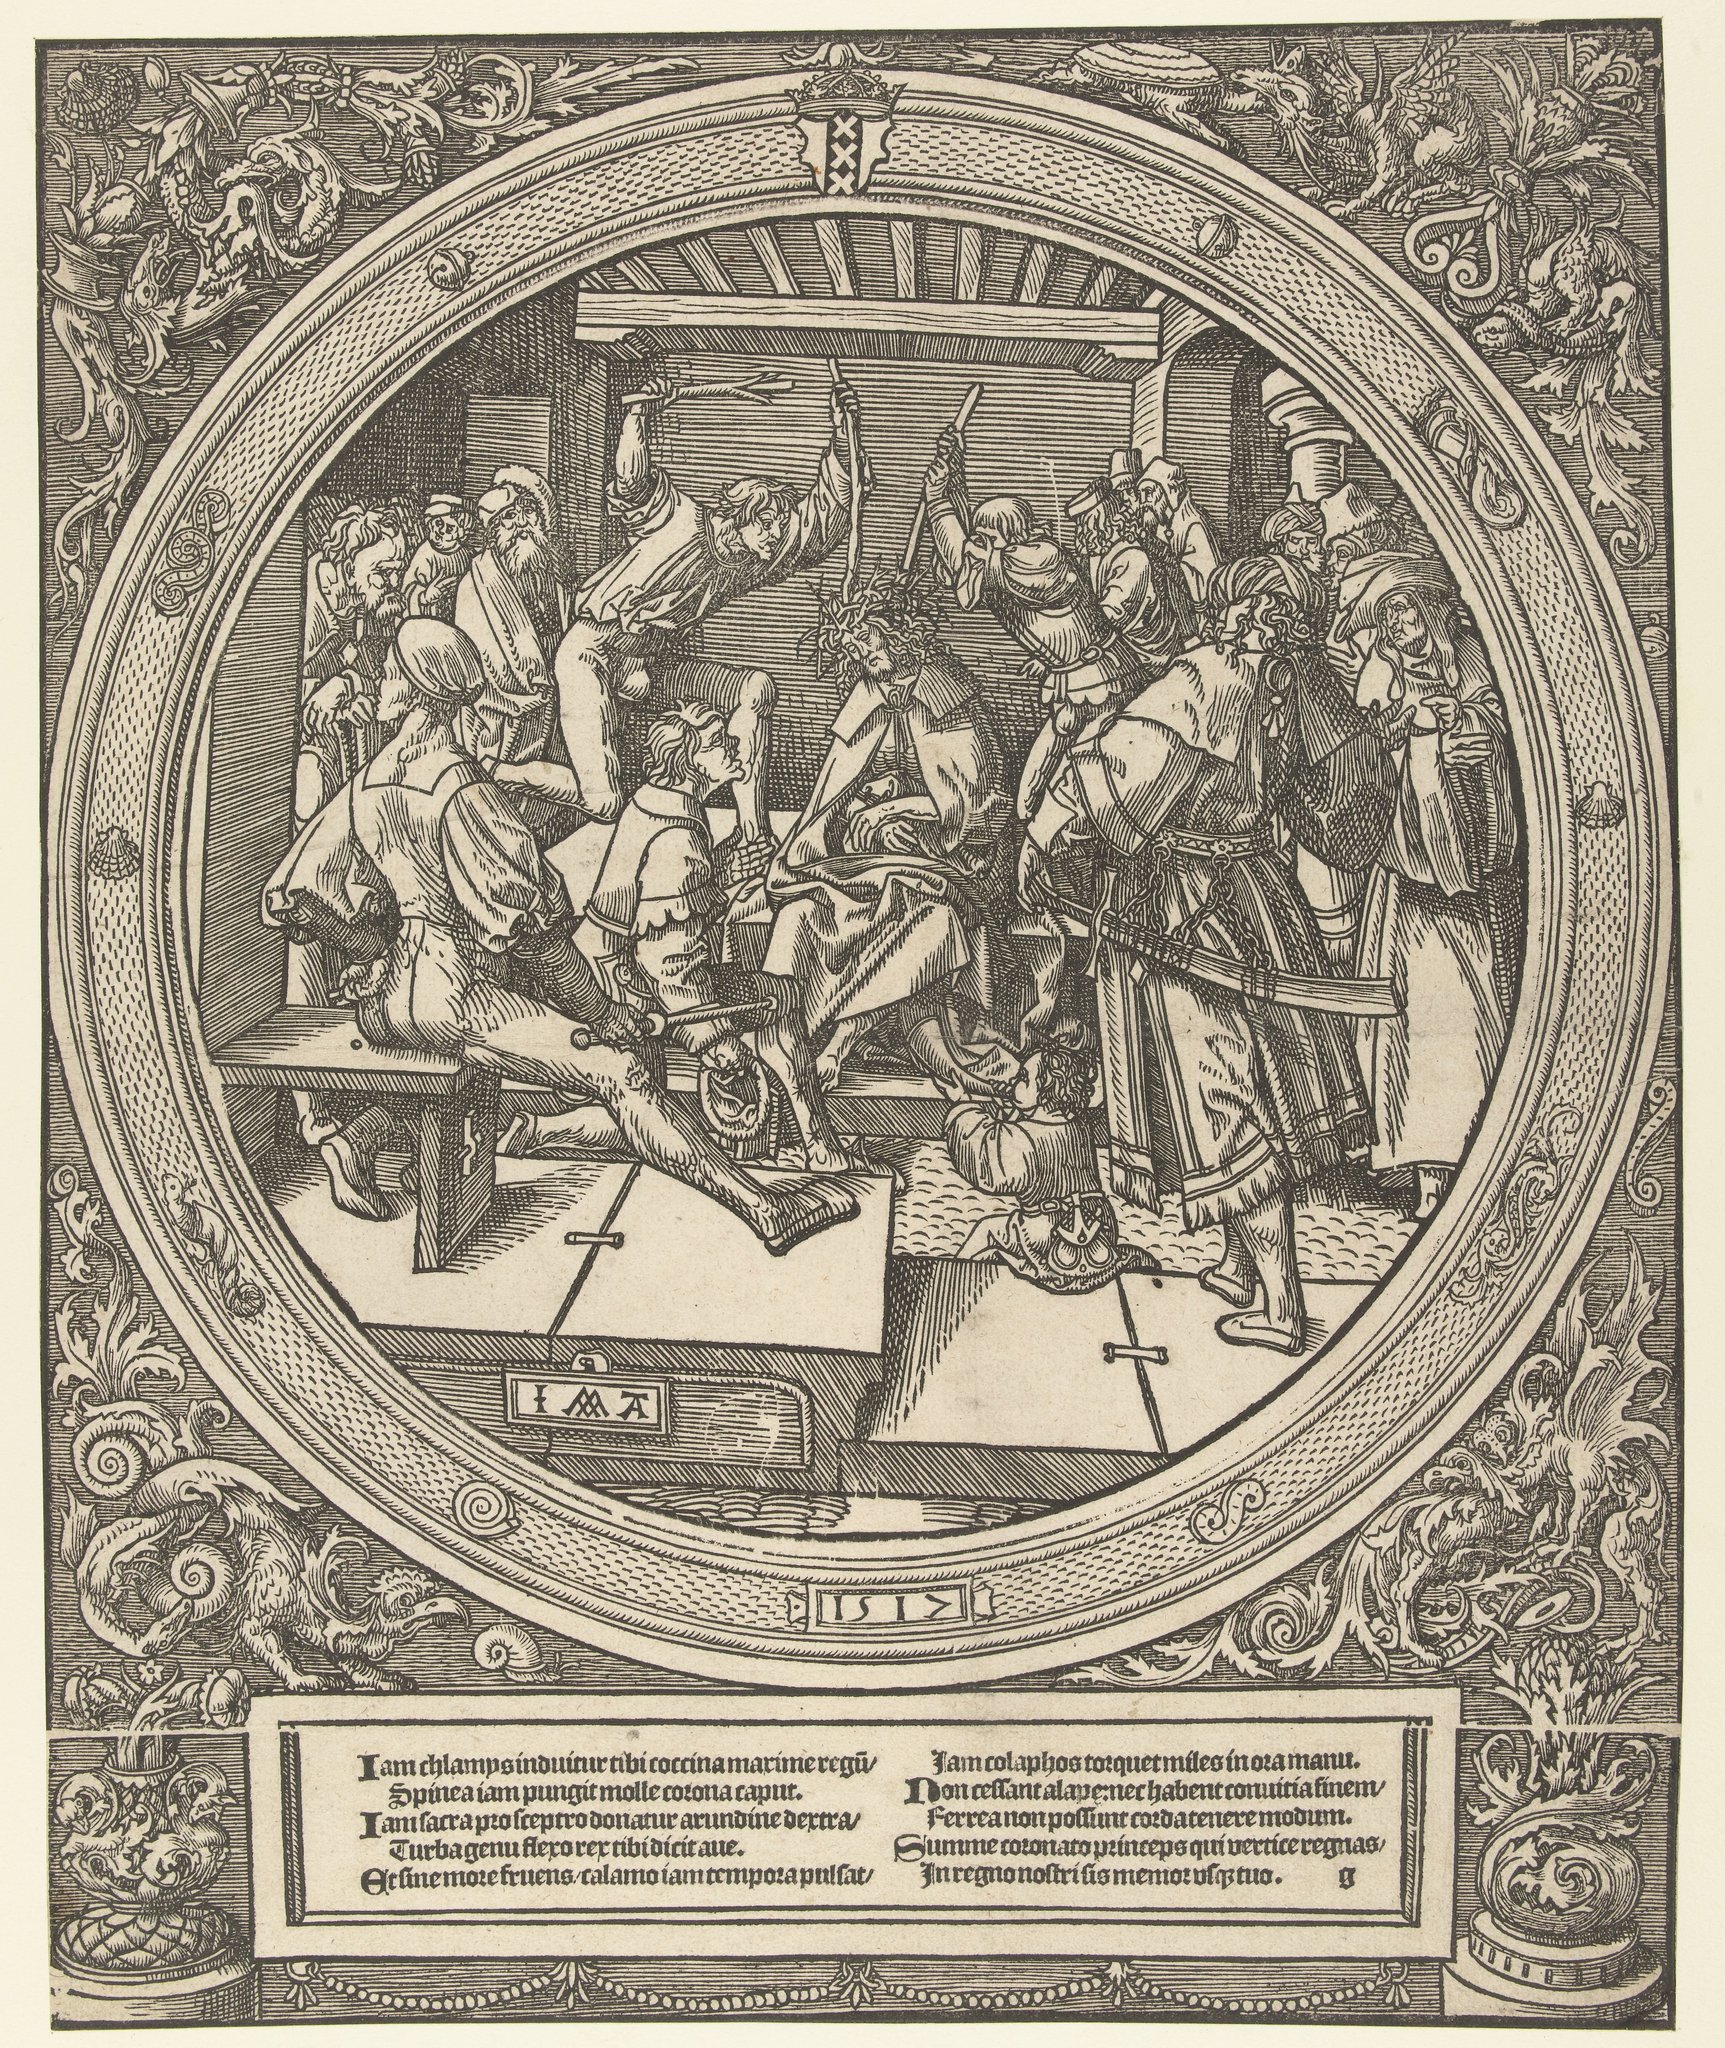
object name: print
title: De doornenkroning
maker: jacob cornelisz van oostsanen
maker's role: draughtsman, painter, print maker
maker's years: 1475-1533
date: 1517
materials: paper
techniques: woodcut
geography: low countries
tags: the crowning with thorns: soldiers with sticks place a thorny crown on christ's head and give him a reed (matthew 27:27-31; mark 15:16-20; john 19:2-3)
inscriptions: collector's mark: Lugt 2165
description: Uit serie van twaalf prenten. Mannen duwen met stokken doornkroon op hoofd Christus. Rond voorstelling ornamentele omlijsting. Onderaan kader met tekst in het Latijn. Gedrukt van meerdere blokken.